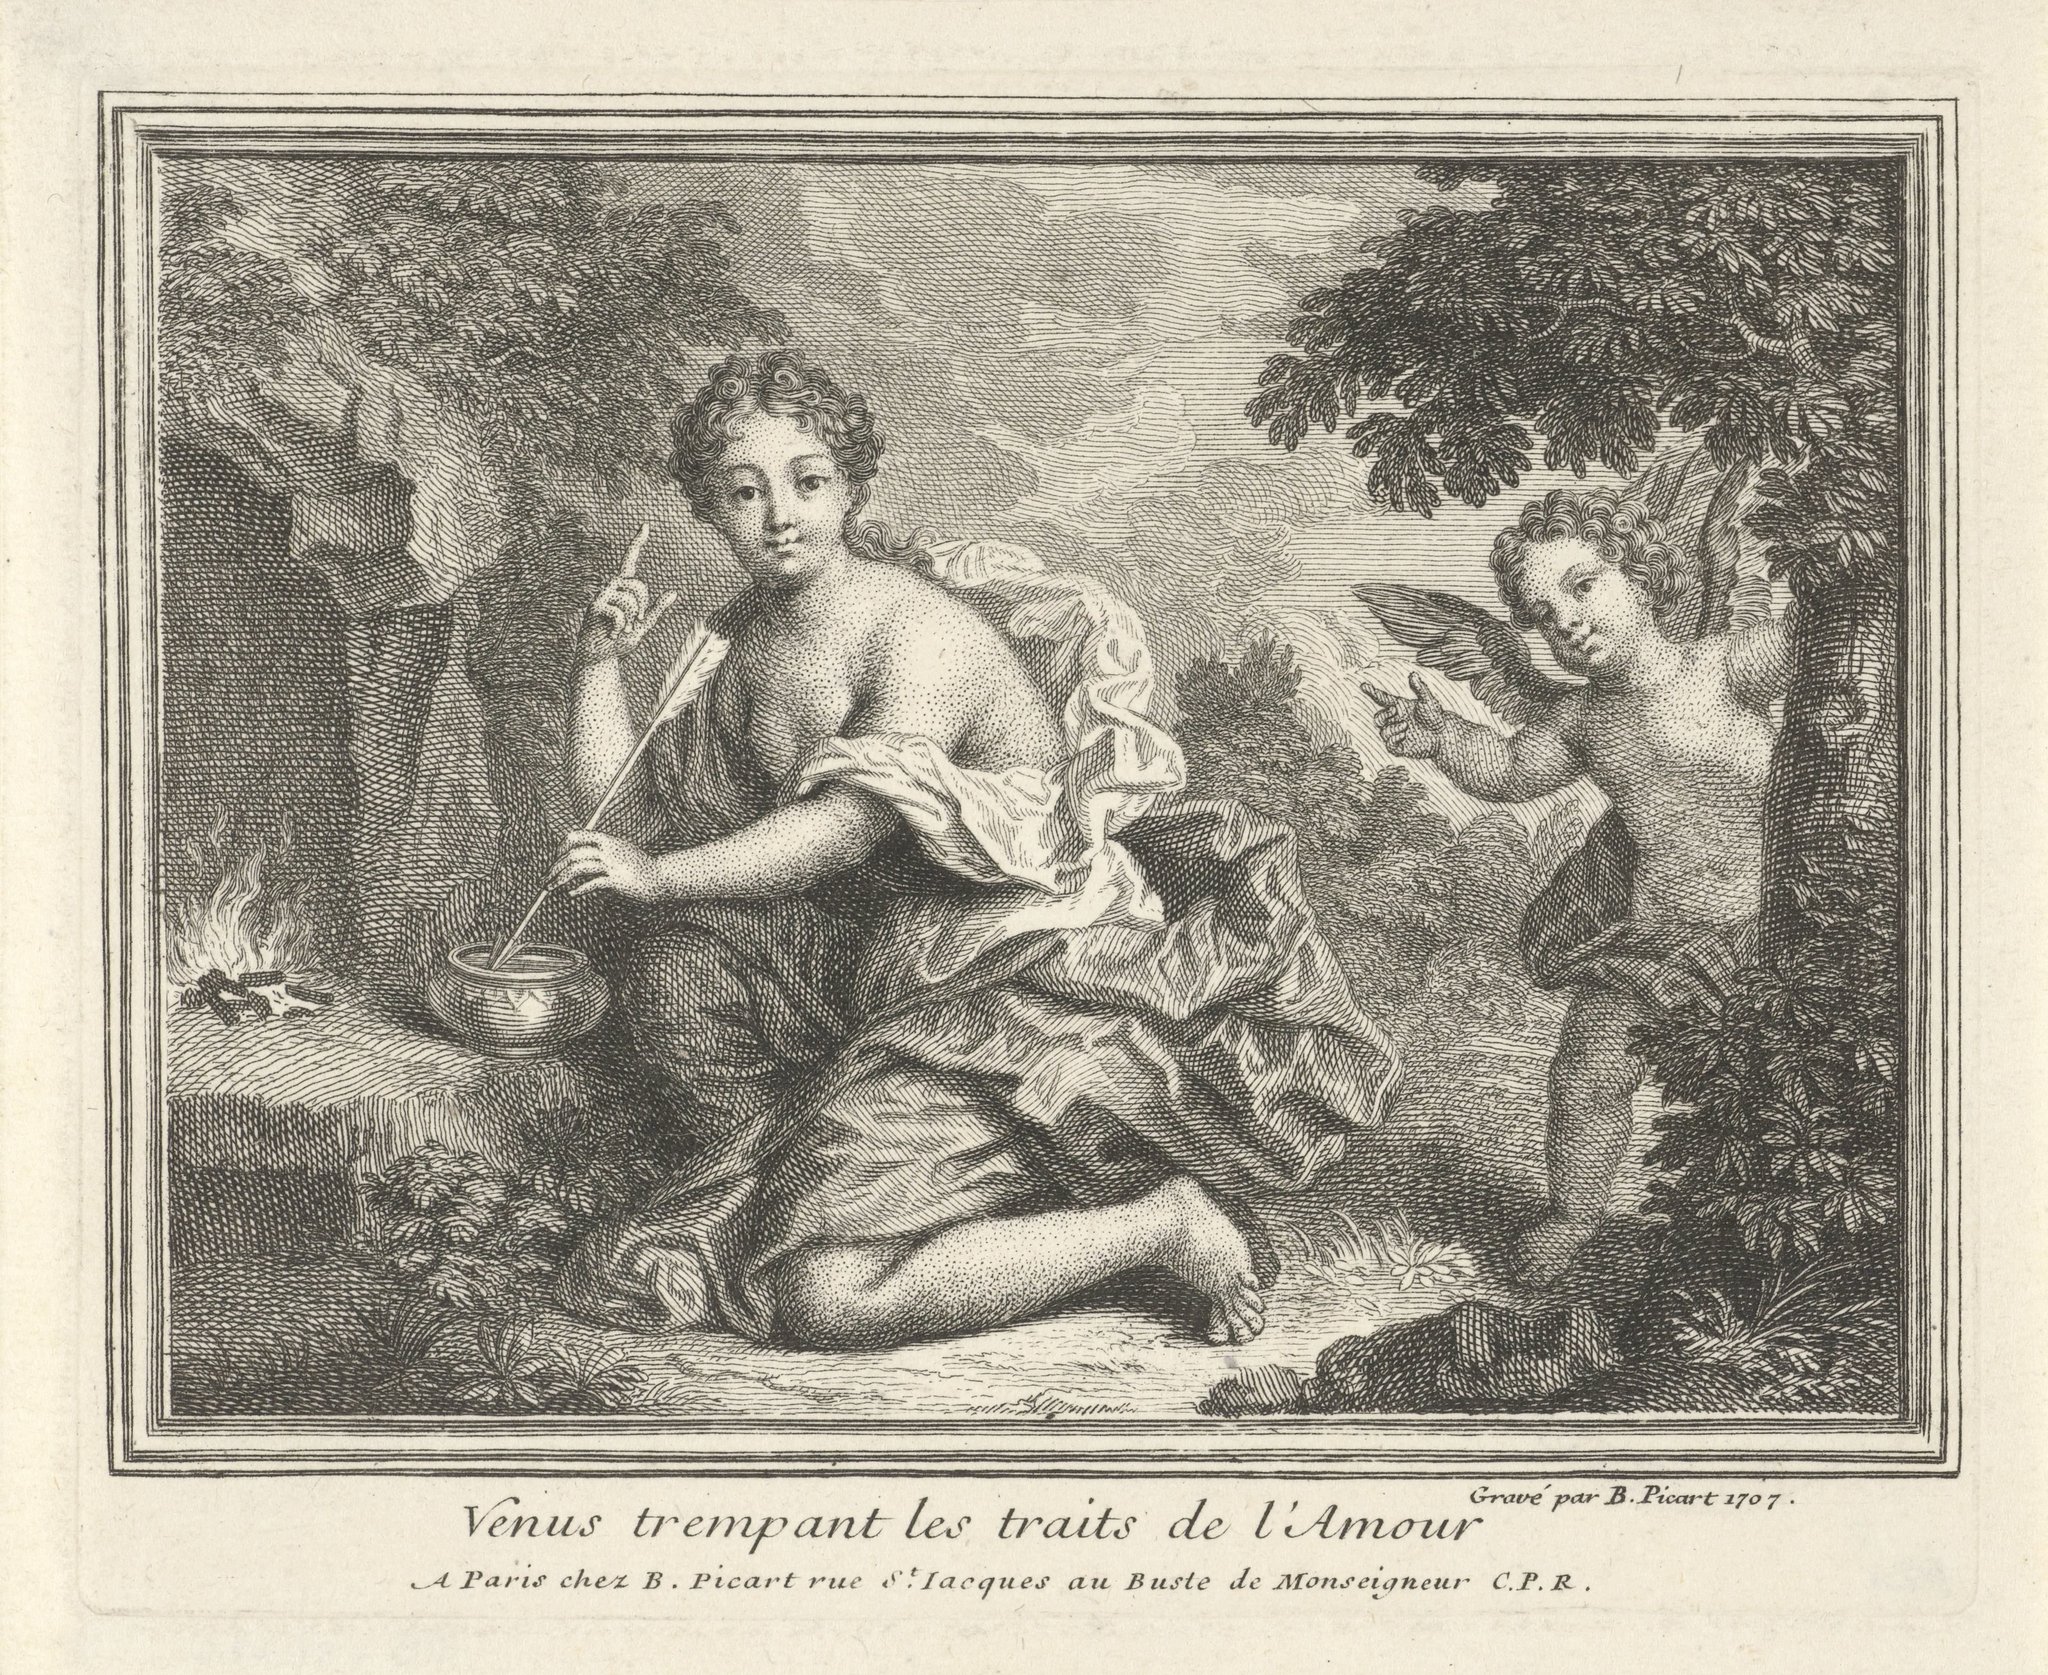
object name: print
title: Venus met de pijlen van Amor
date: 1707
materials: paper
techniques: engraving, etching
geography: paris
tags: venus taking care of cupid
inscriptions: collector's mark: Lugt 240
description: Landschap met Venus die de pijlen van Amor in een vuurpot houdt. Amor kijkt toe vanachter een boom.